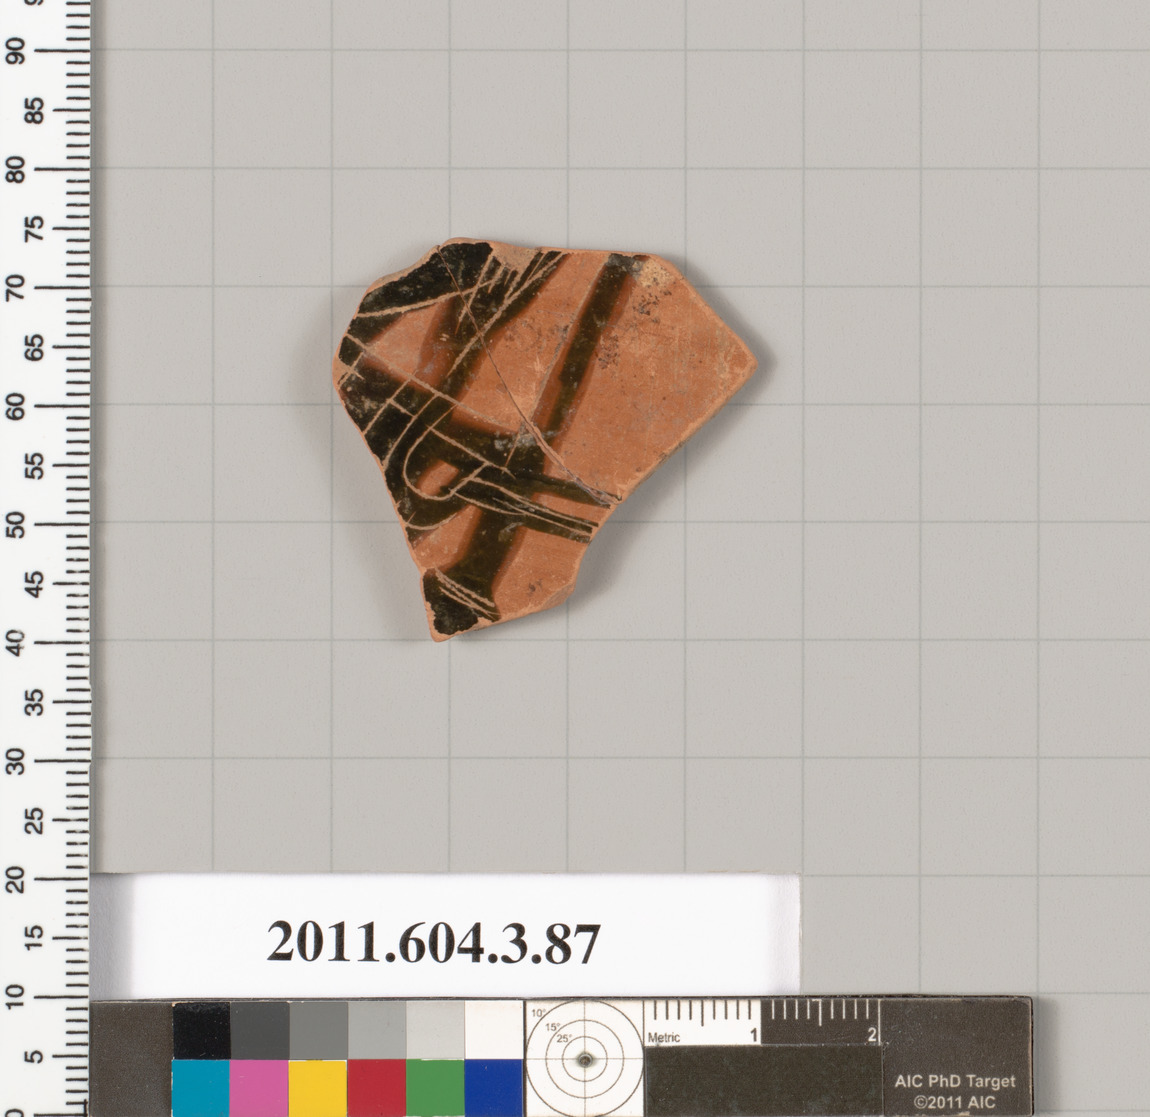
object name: amphora fragment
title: Terracotta fragment of an amphora (jar)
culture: greek, attic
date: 534-501 BCE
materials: terracotta